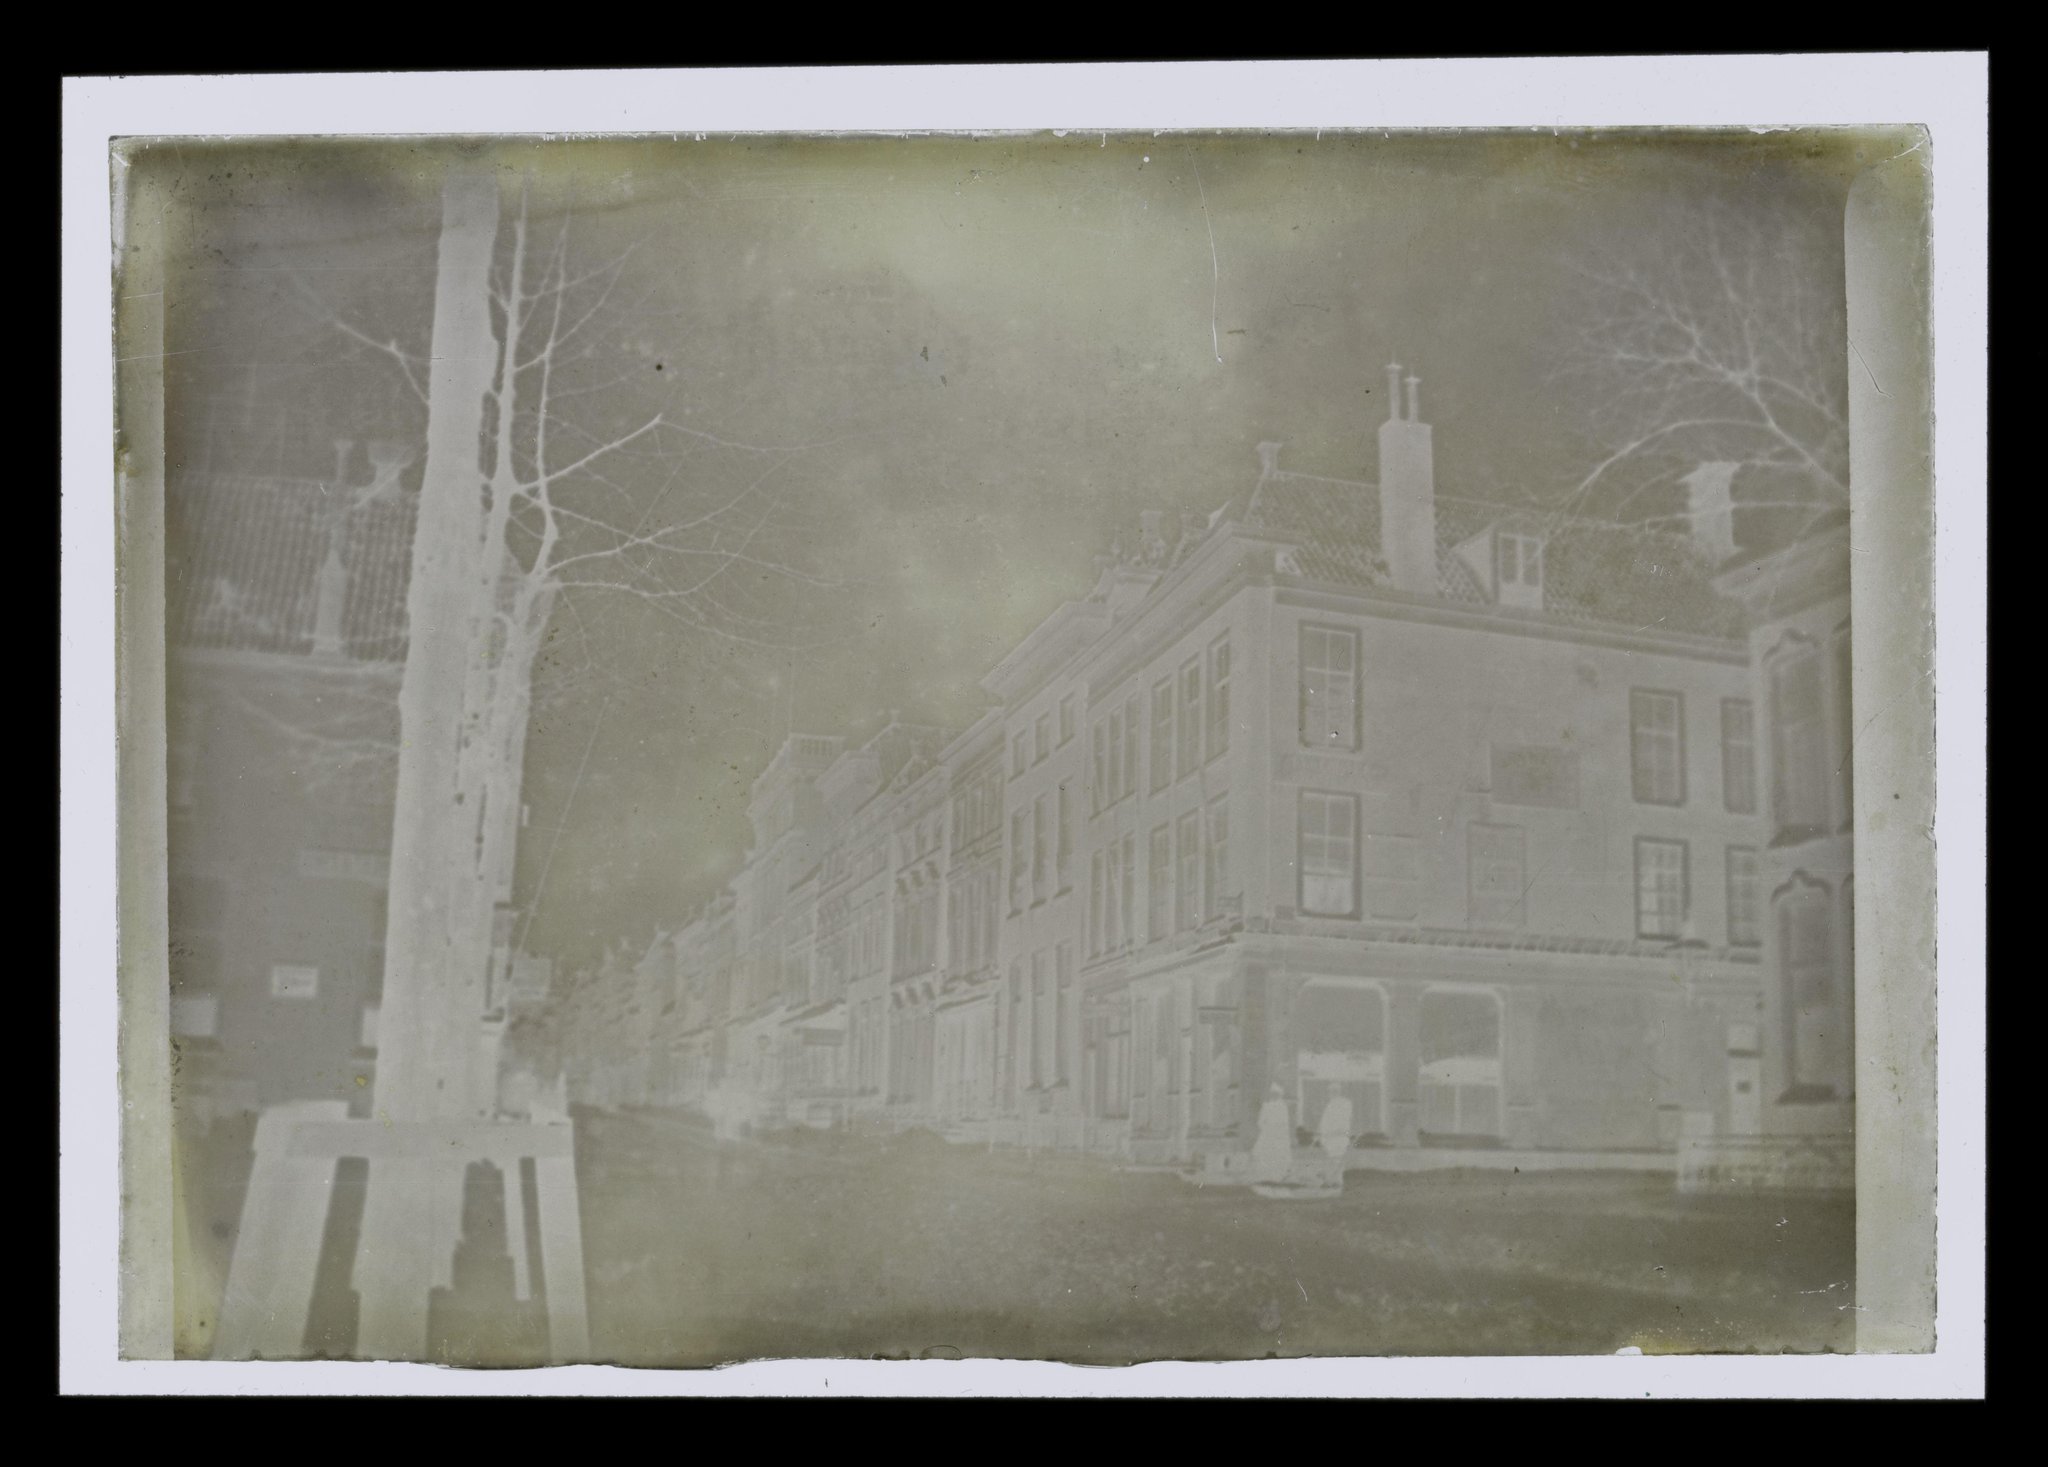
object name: glasnegatief, glasplaatnegatief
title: Gezicht op een straat, Nederland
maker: laurens lodewijk kleijn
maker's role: draughtsman, painter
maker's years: 1826-1909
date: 1865-1900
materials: glass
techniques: collodion process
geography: netherlands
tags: street, netherlands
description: Onderdeel van groep glasnegatieven uit de nalatenschap van de schilder Laurens Lodewijk Kleijn, stillevens, portretten, zelfportretten en kunstreproducties.